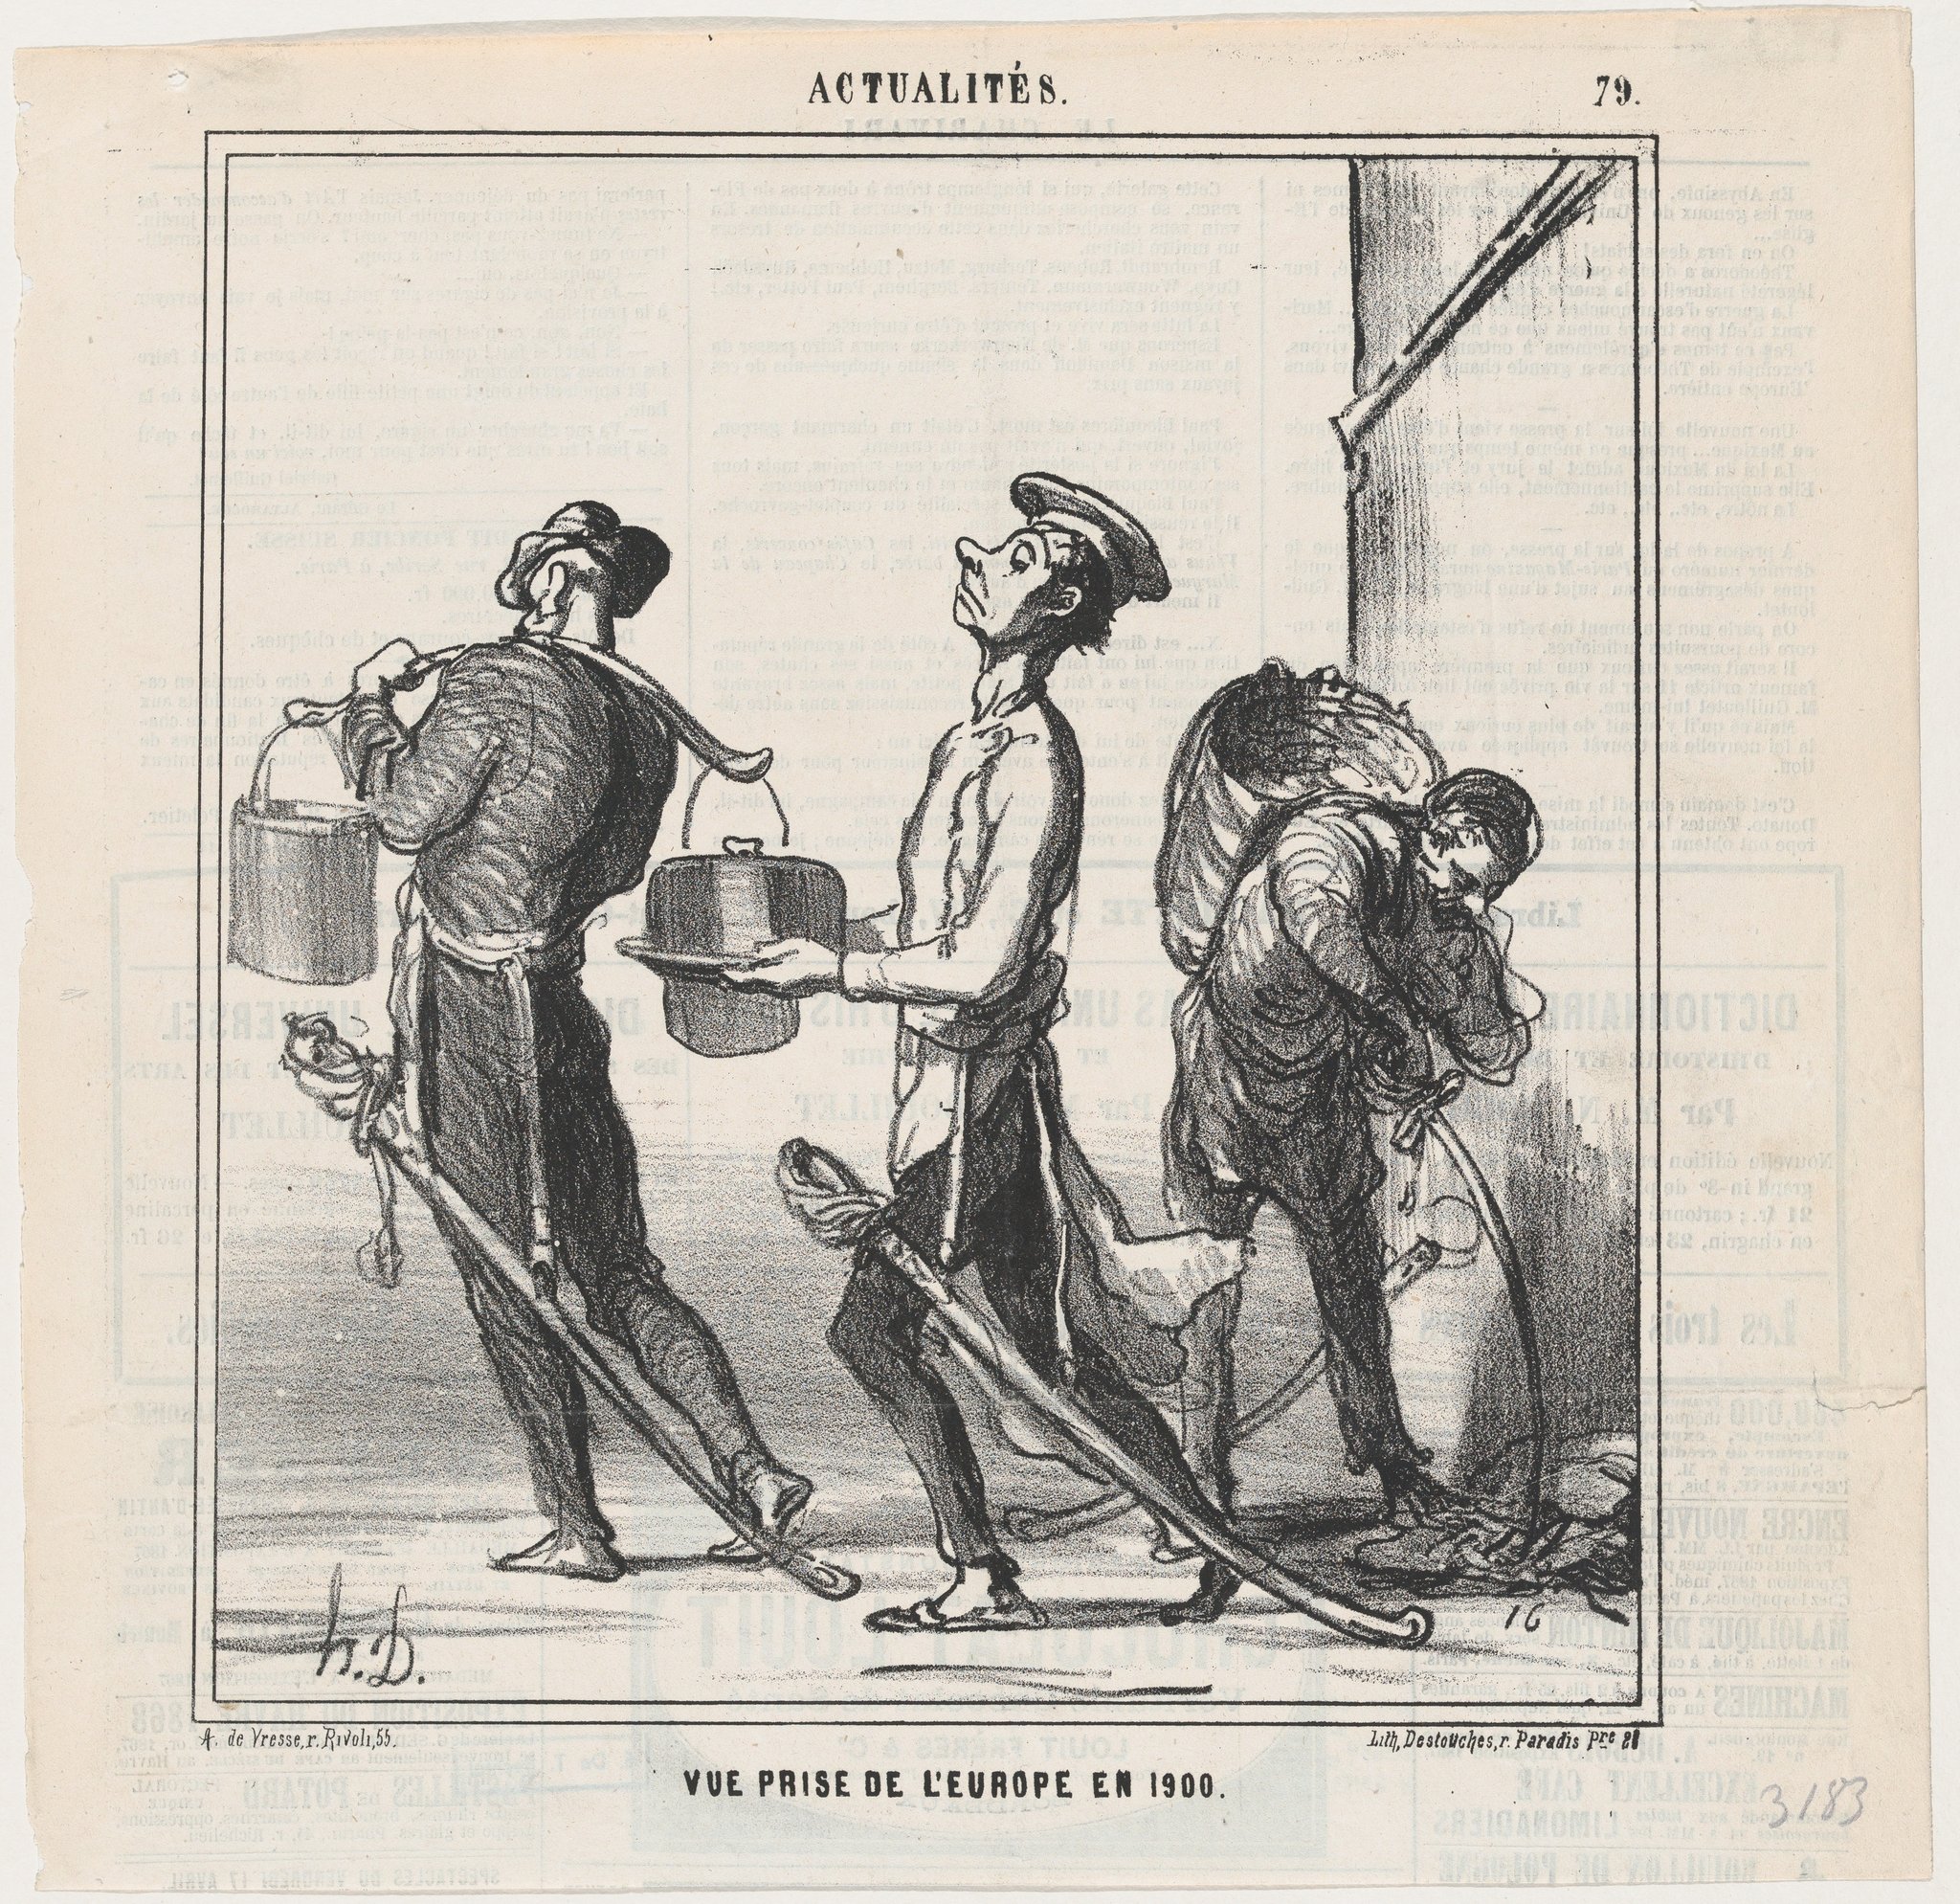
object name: print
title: View of Europe in 1900, from "News of the day"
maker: honoré daumier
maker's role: artist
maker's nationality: french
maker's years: 1808-1879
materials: paper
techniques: lithograph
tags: satire,men